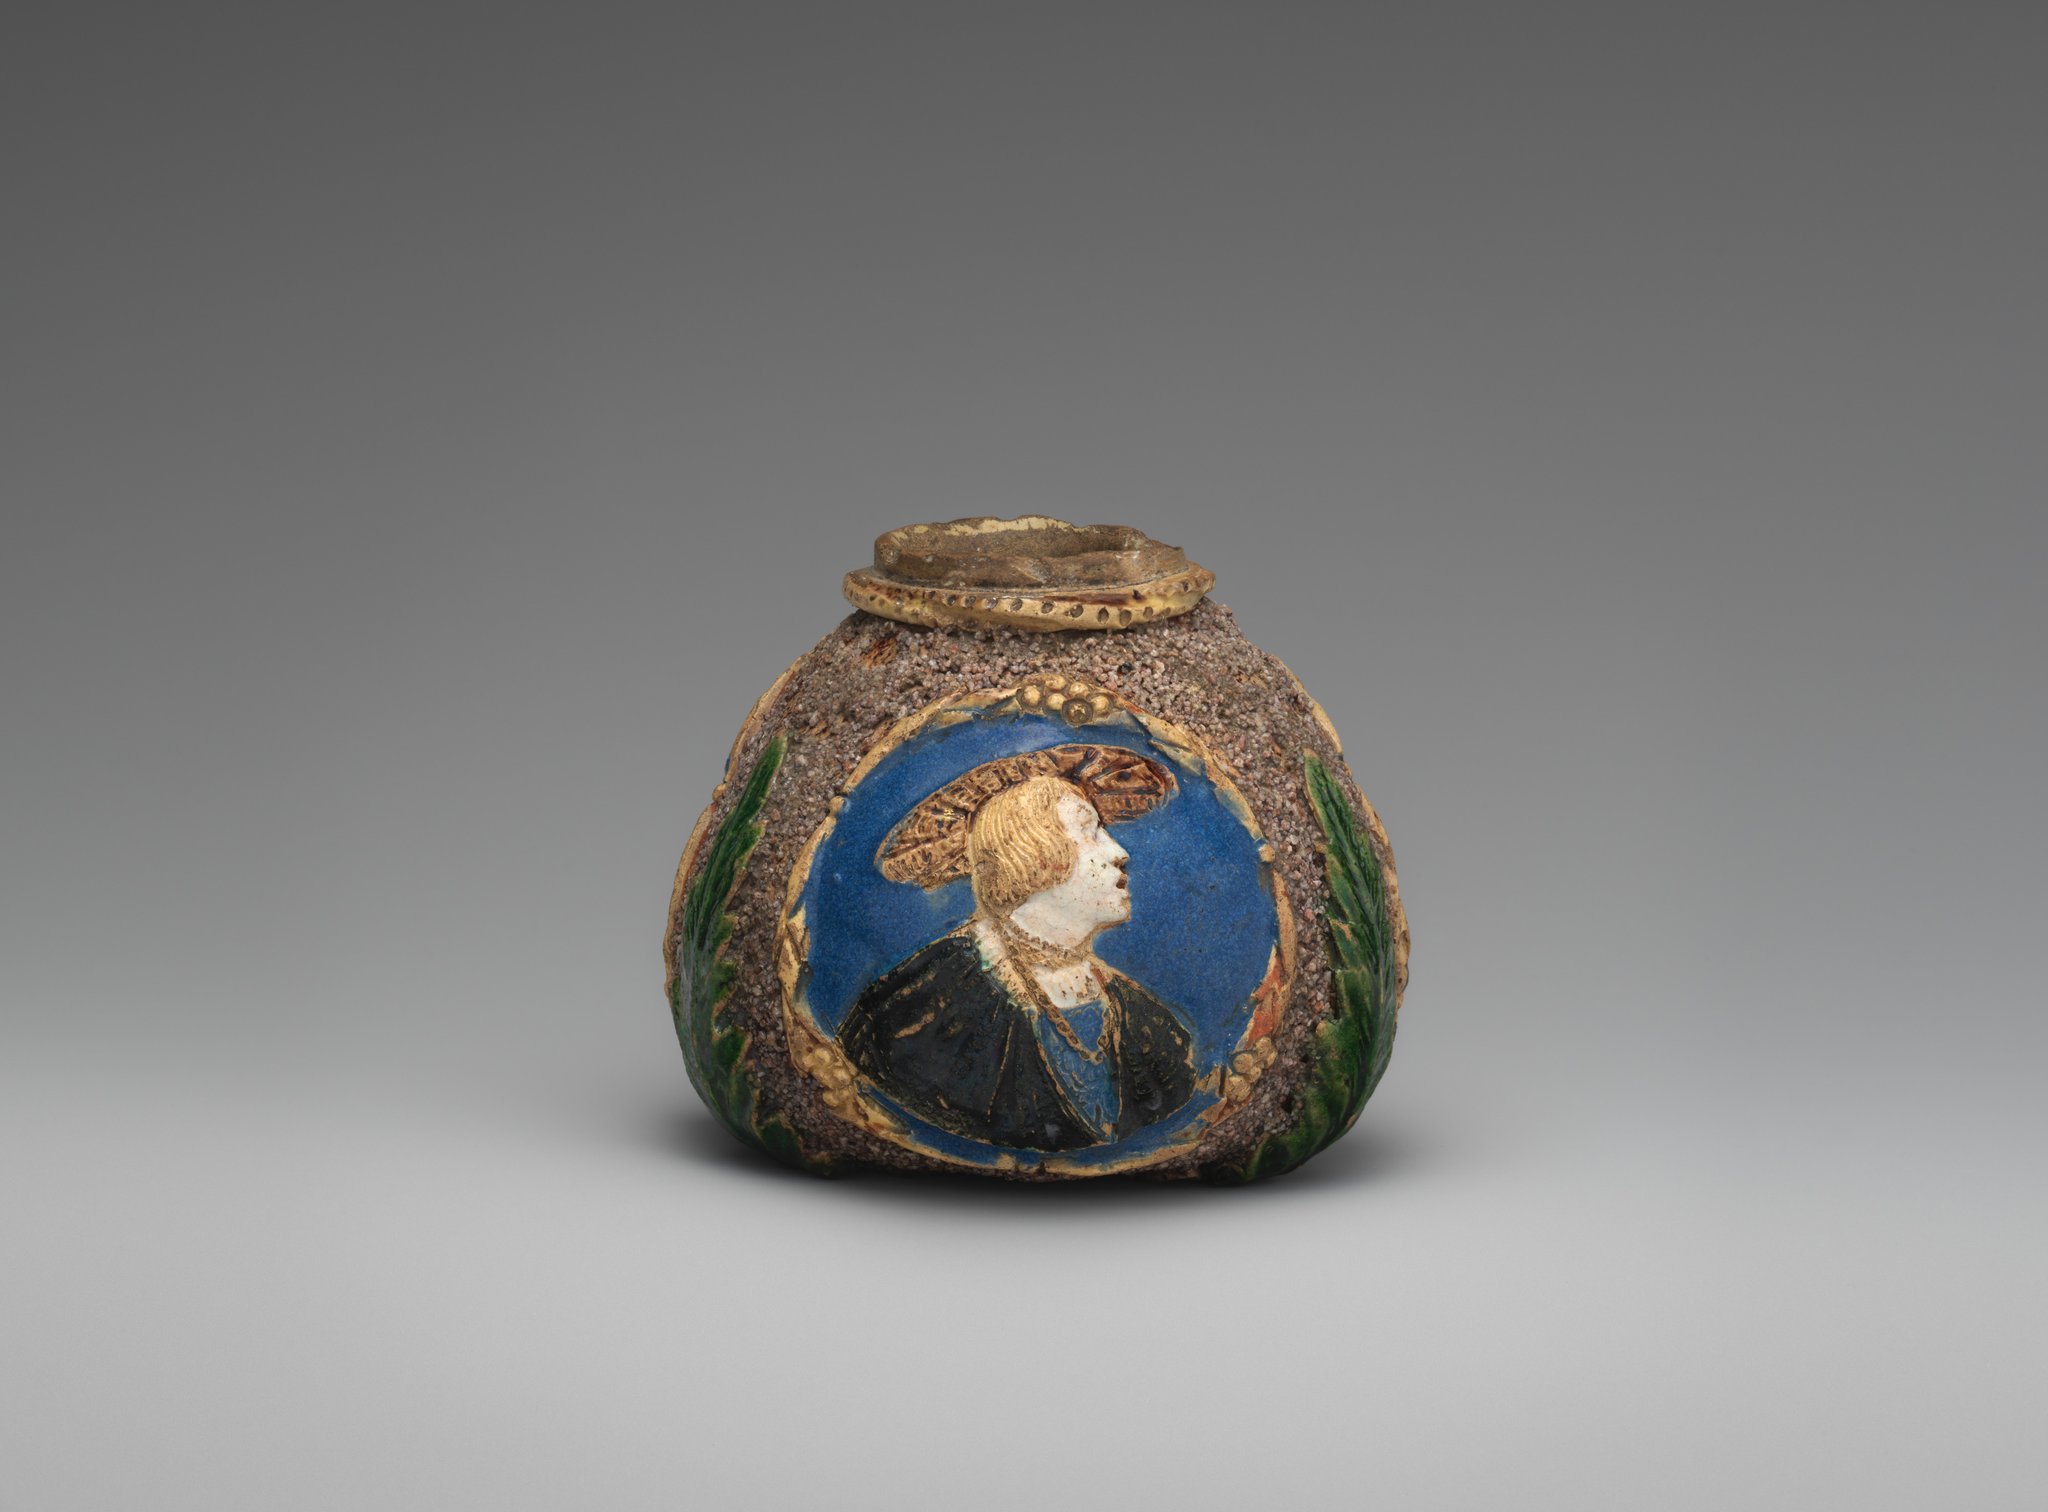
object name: pot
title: Hafner ware pot with portraits of Ferdinand I, King of Hungary (1503–64), Anne of Hungary (1503–47), and probably Emperor Charles V (1519–56)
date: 1530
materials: earthenware, glaze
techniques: firing, gilding, polychrome